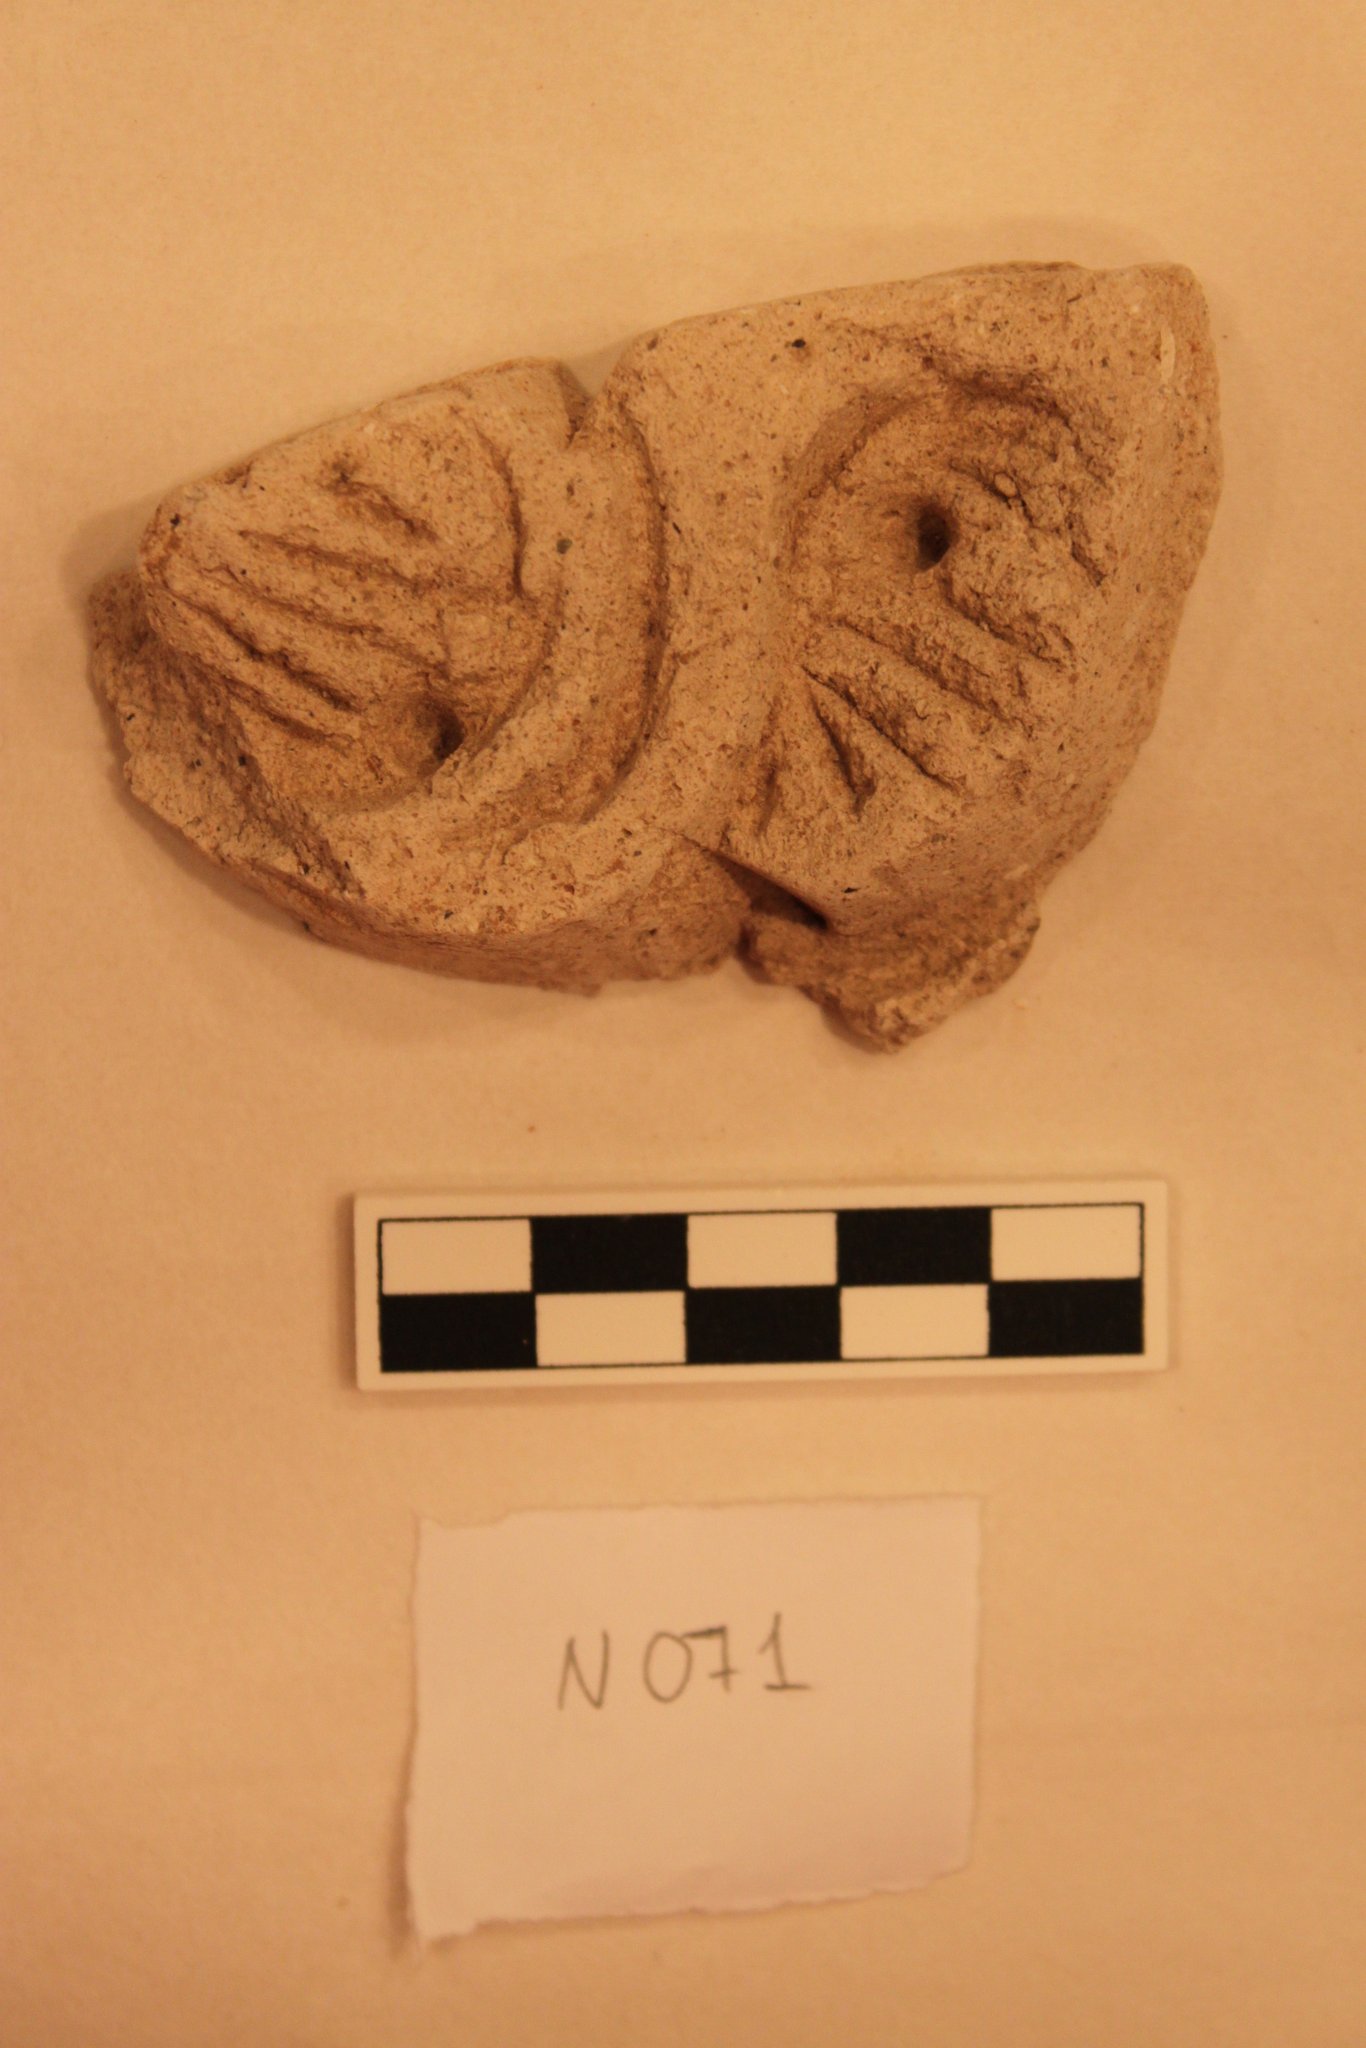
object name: fragment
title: Stucco Fragment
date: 701-1200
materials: plaster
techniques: carving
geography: iran